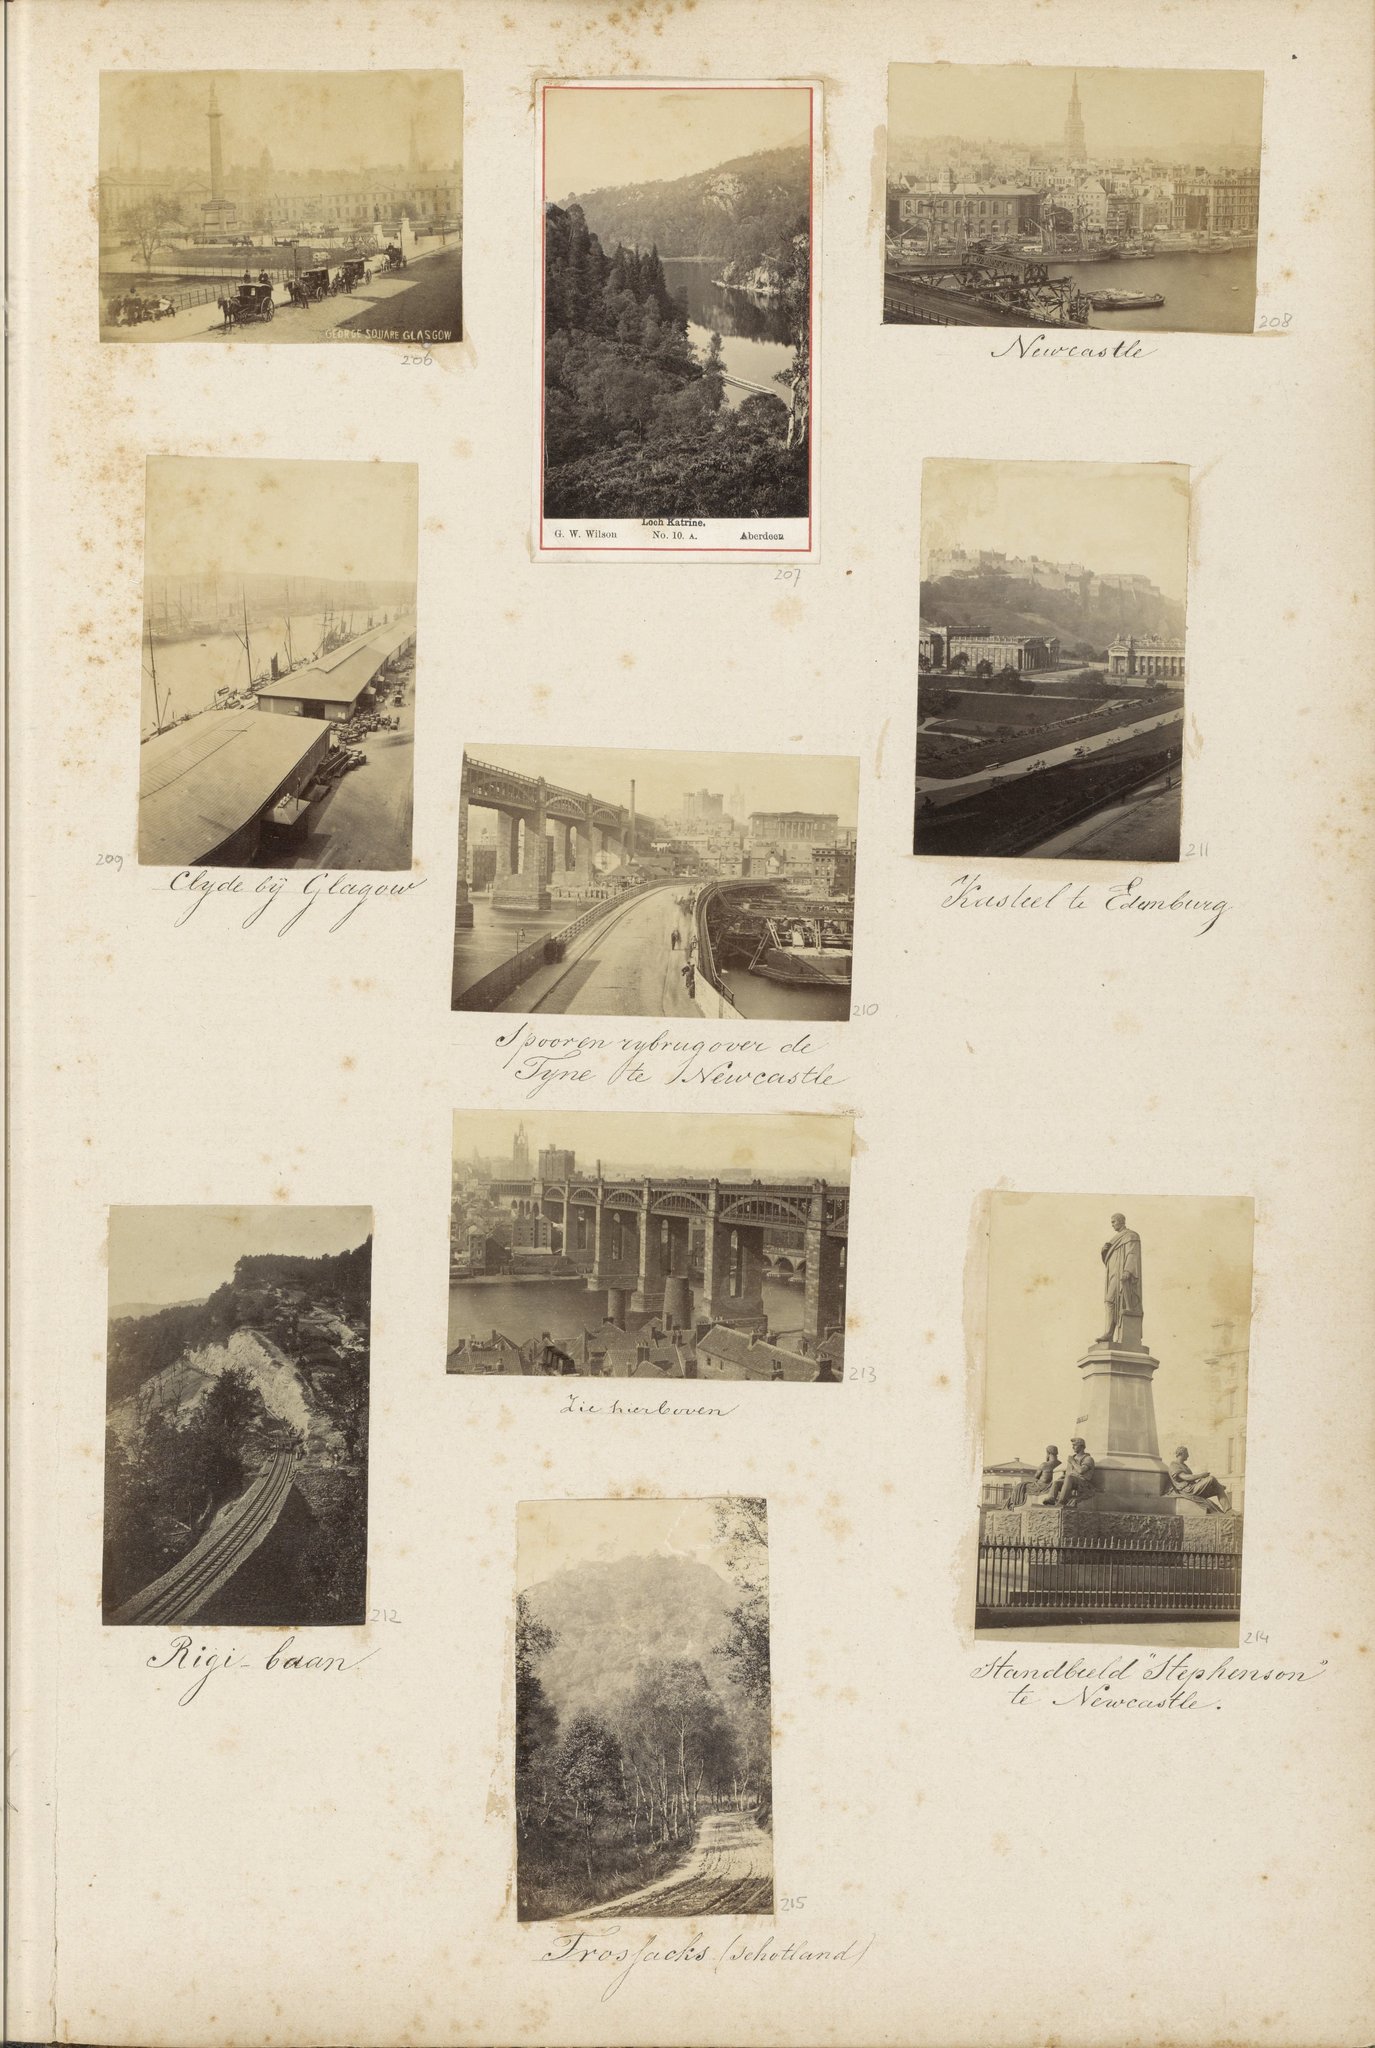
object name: album leaf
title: Gezicht op Edinburgh met het kasteel, de Royal Scottish Academy Building en de National Gallery of Scotland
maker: Anonymous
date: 1870-1880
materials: paper, photographic support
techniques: albumen print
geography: edinburgh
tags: edinburgh castle, edinburgh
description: Onderdeel van Fotoalbum van Robert Daniel Crommelin (1841-1907).